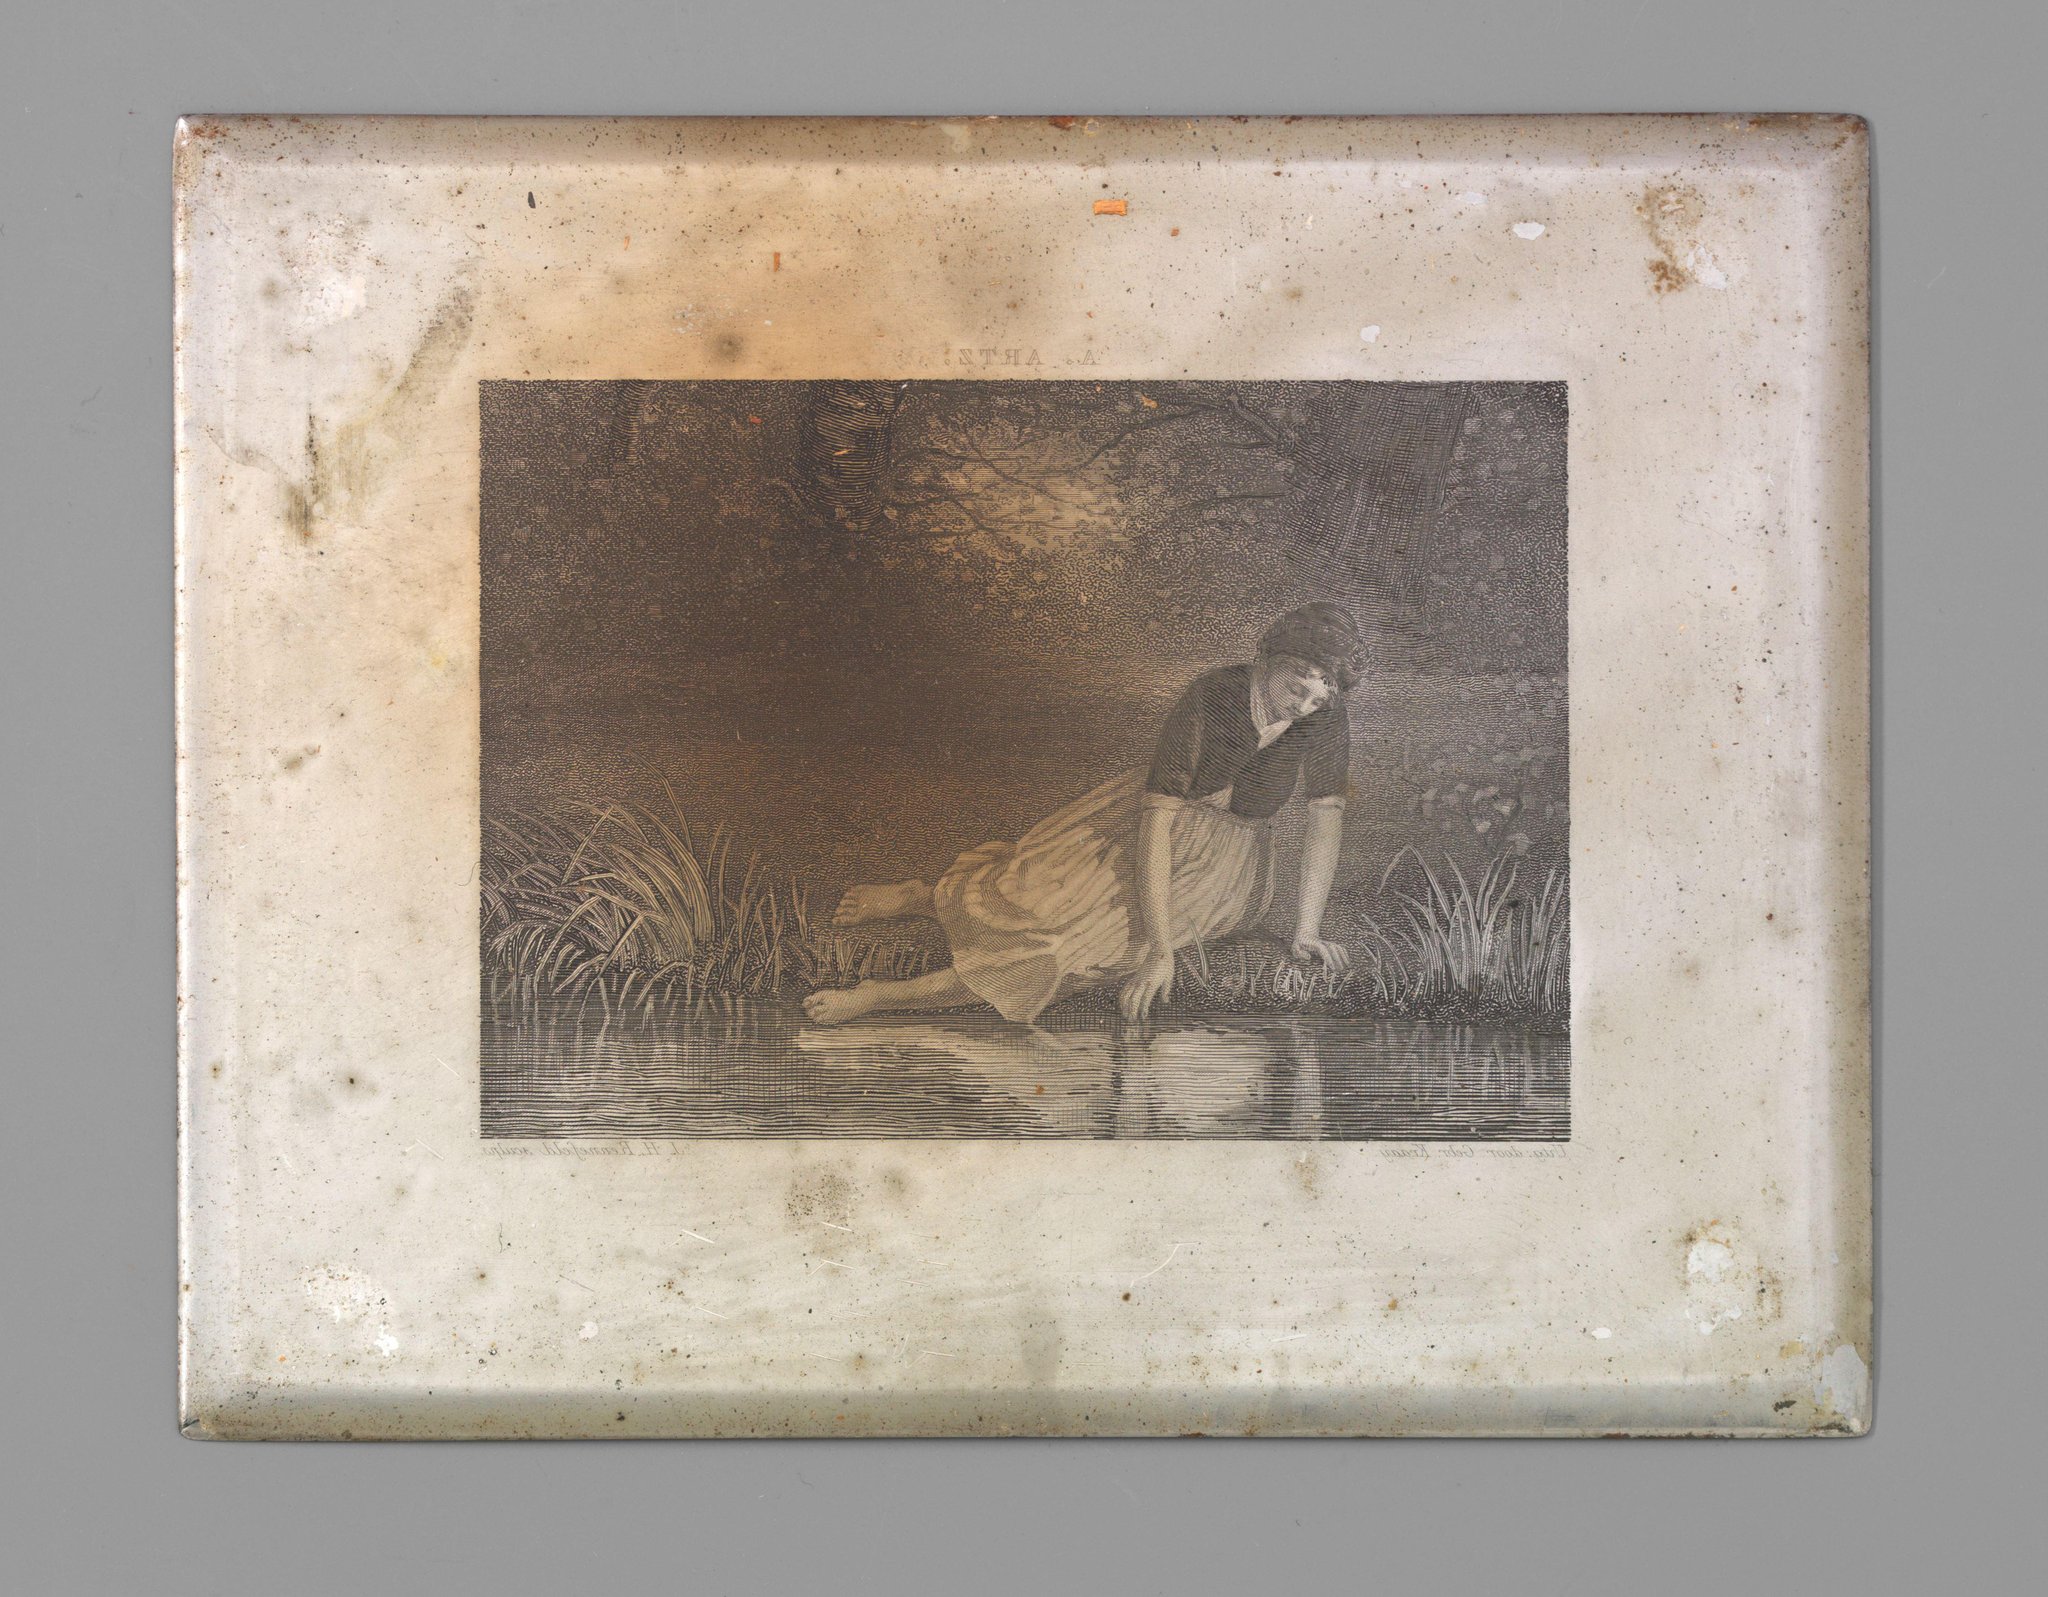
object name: staalplaat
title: Meisje zittend aan water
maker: johann heinrich maria hubert rennefeld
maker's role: print maker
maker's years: 1832-1877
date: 1847-1870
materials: steel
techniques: engraving